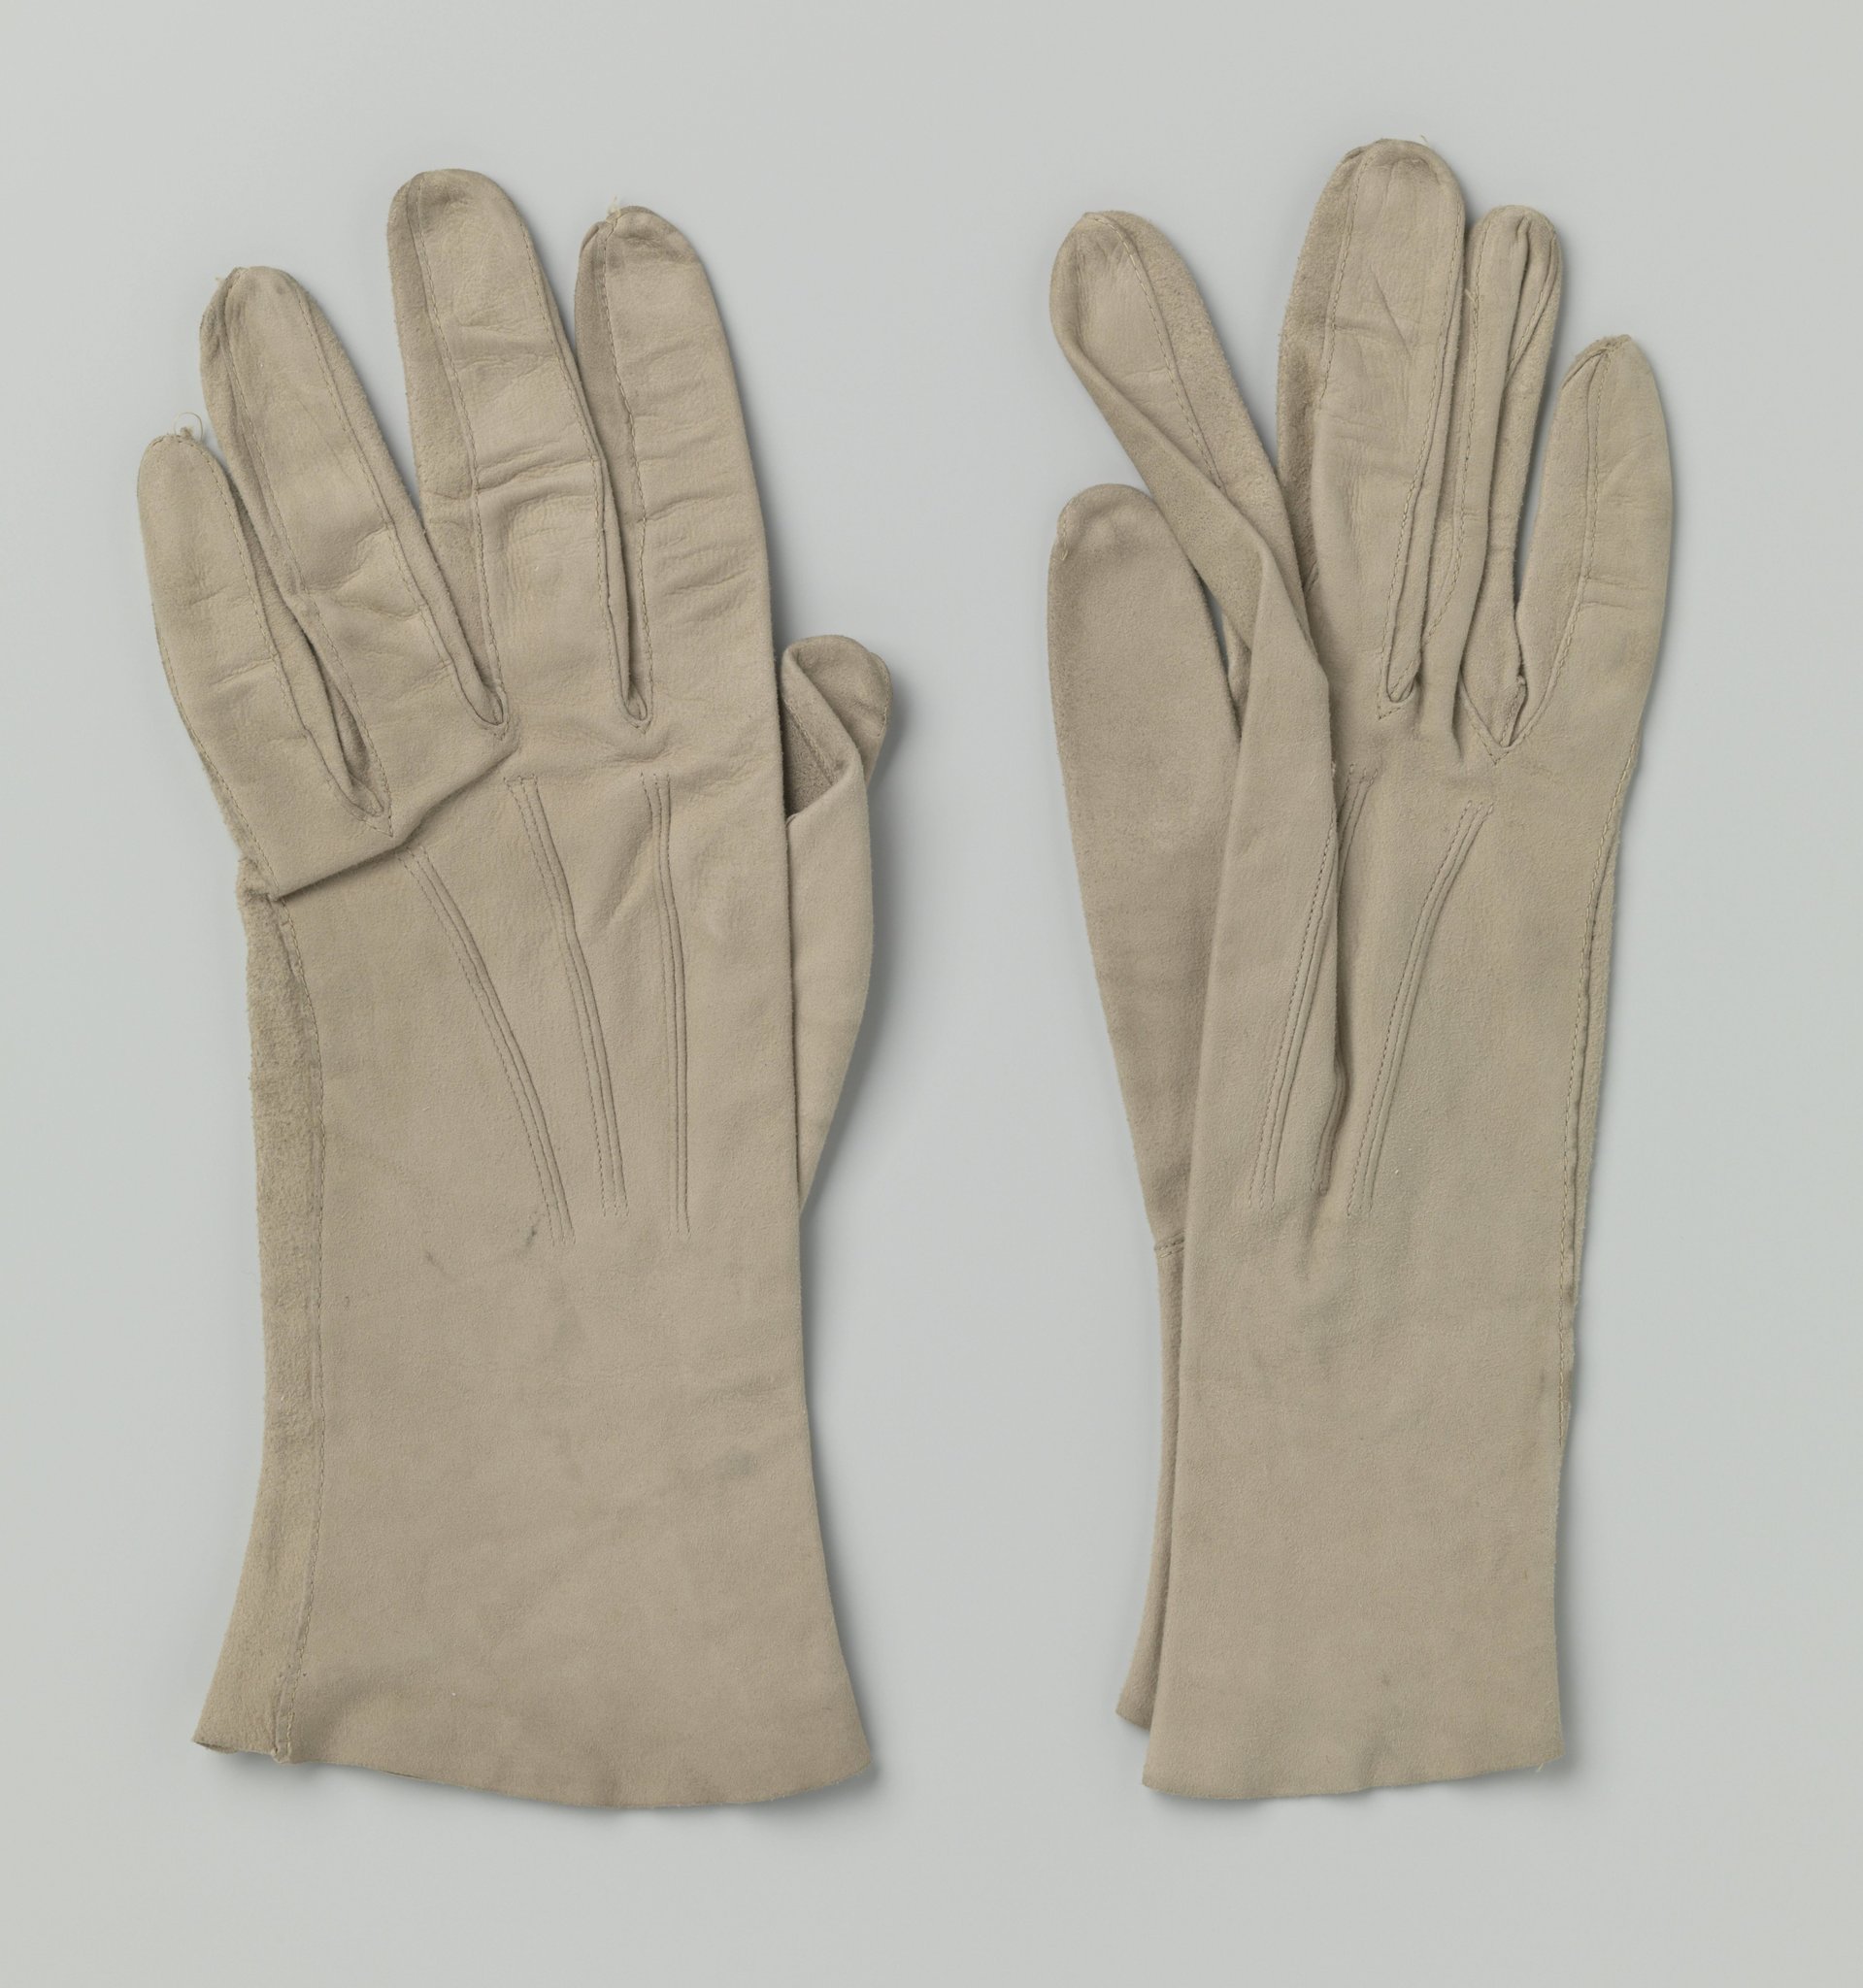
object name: clothing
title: Handschoen in leverkleurig zeemleer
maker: Anonymous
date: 1926-1950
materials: leather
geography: western europe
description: Rechter handschoen in leverkleurig zeemleer. Op de rug drie uitstralende koorden.